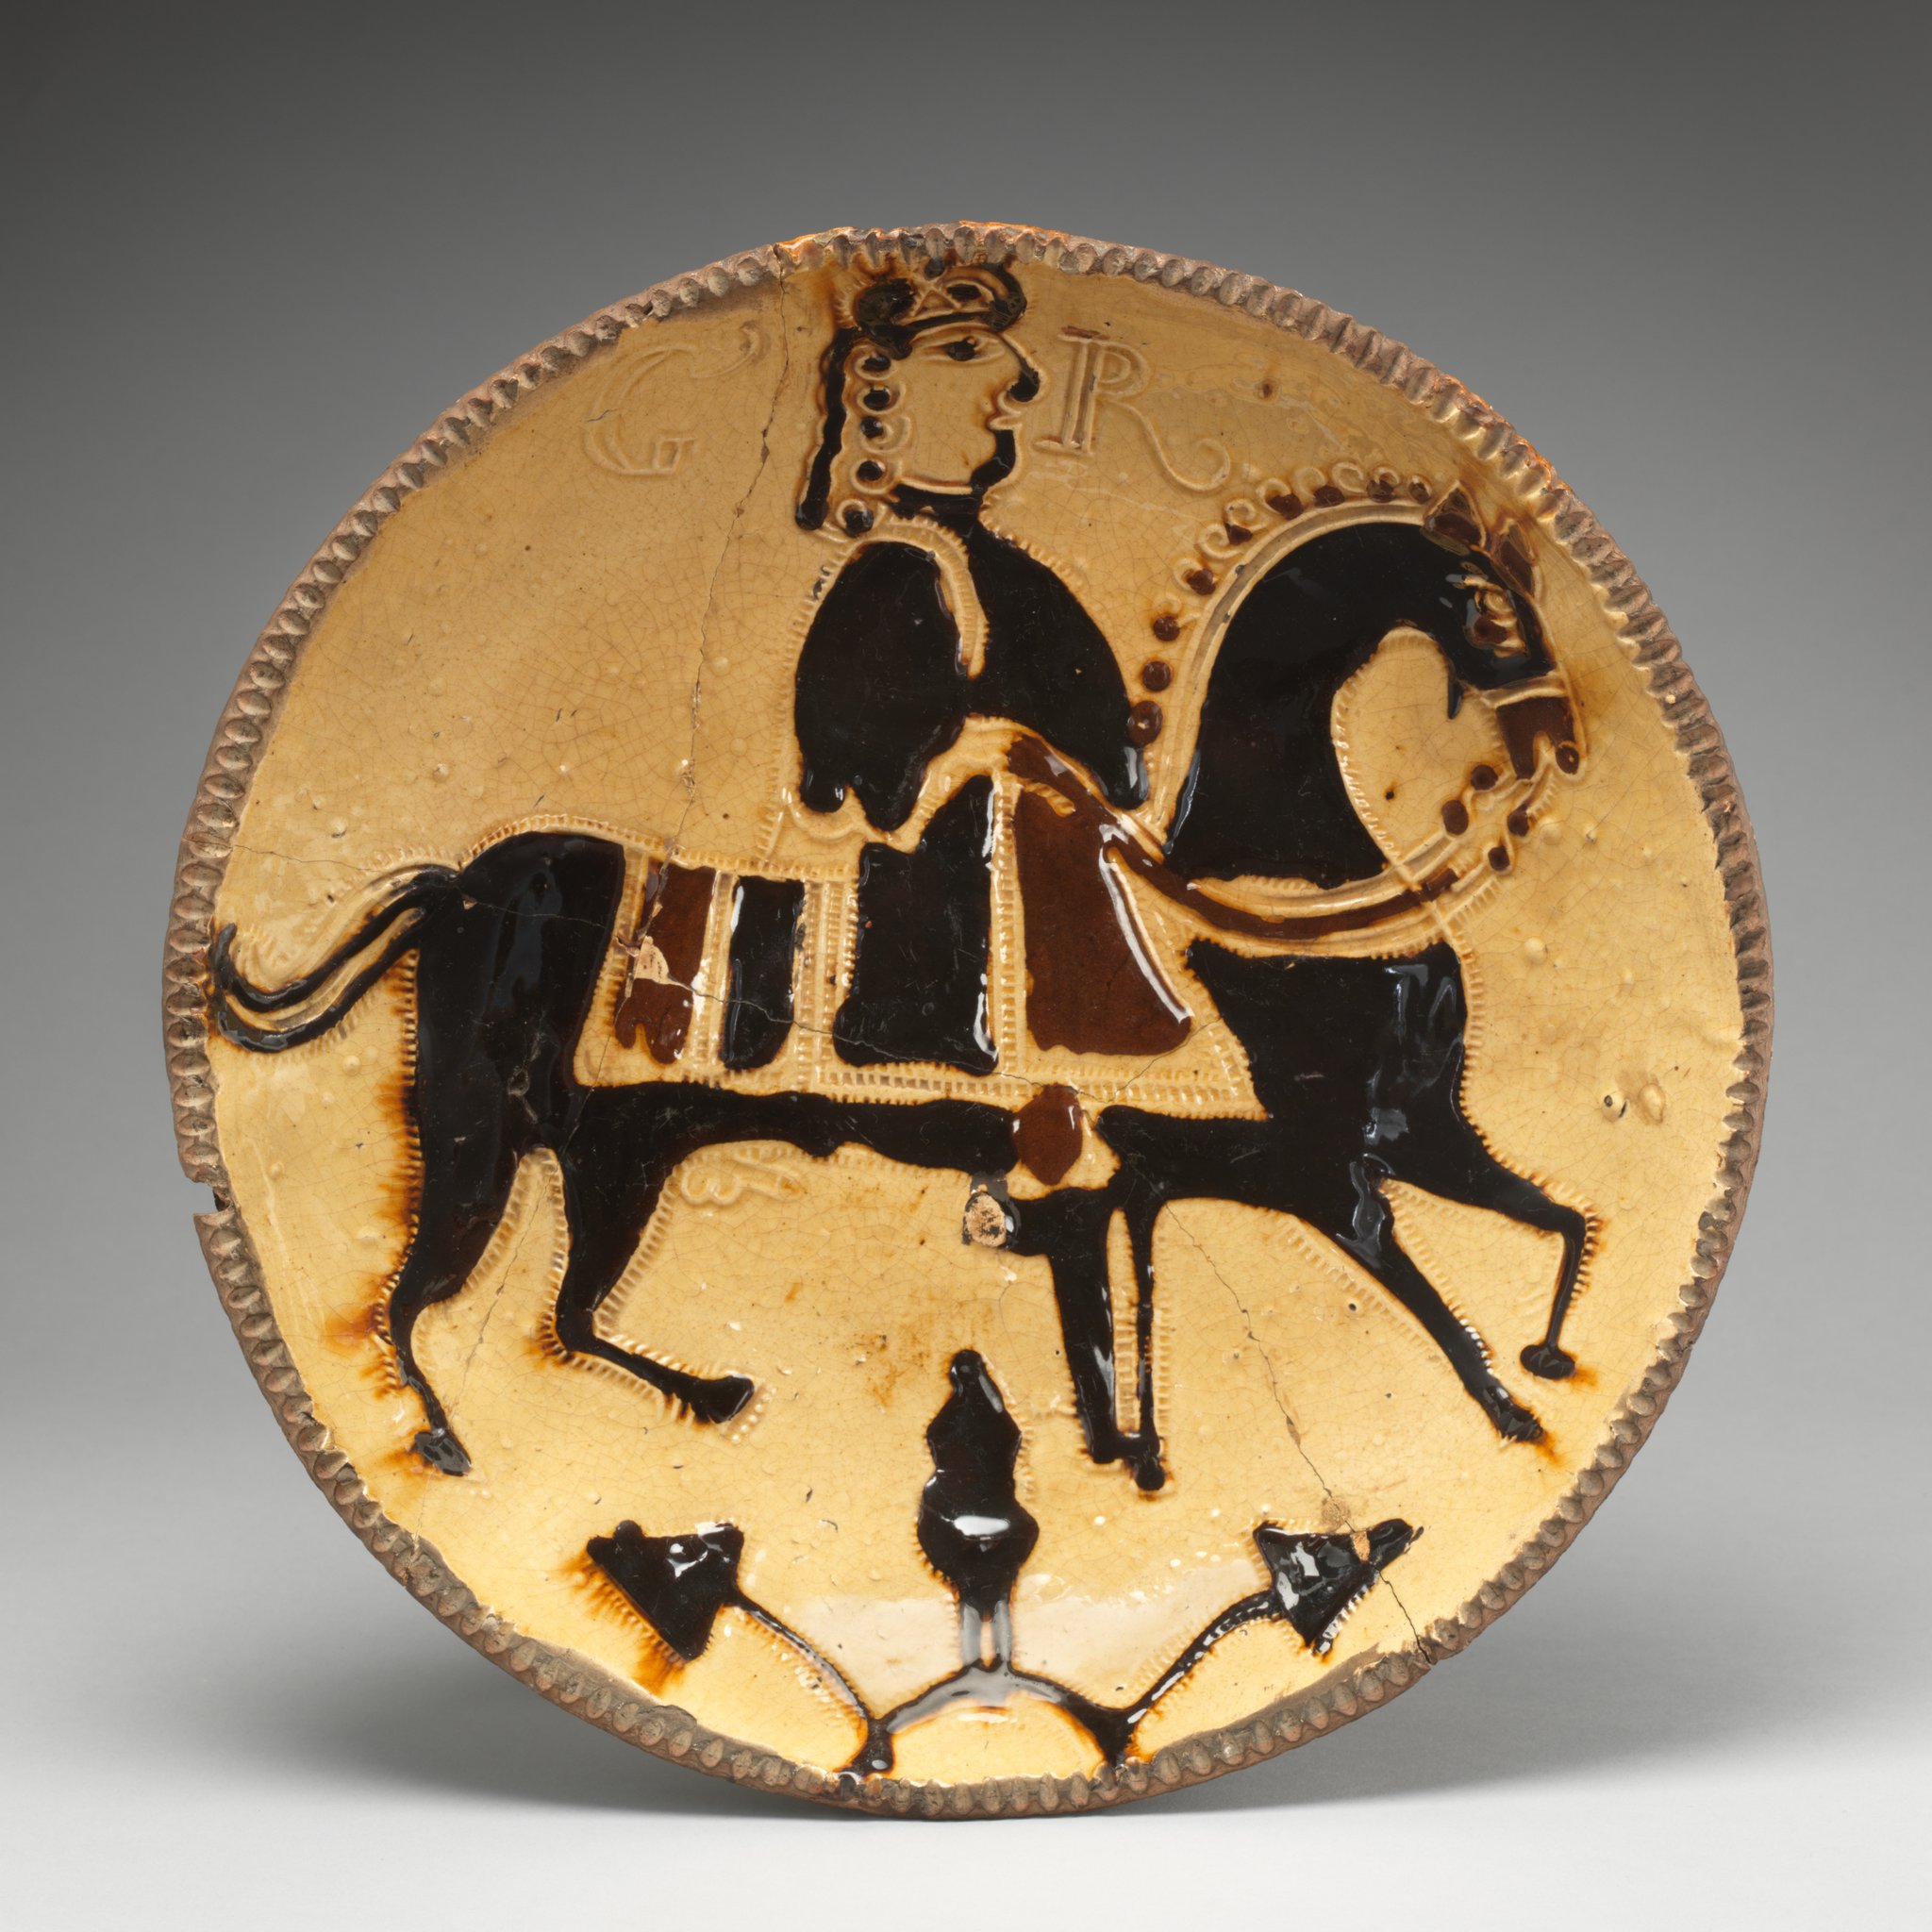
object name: dish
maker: samuel malkin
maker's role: maker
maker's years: 1668-1741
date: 1701-1750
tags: horses